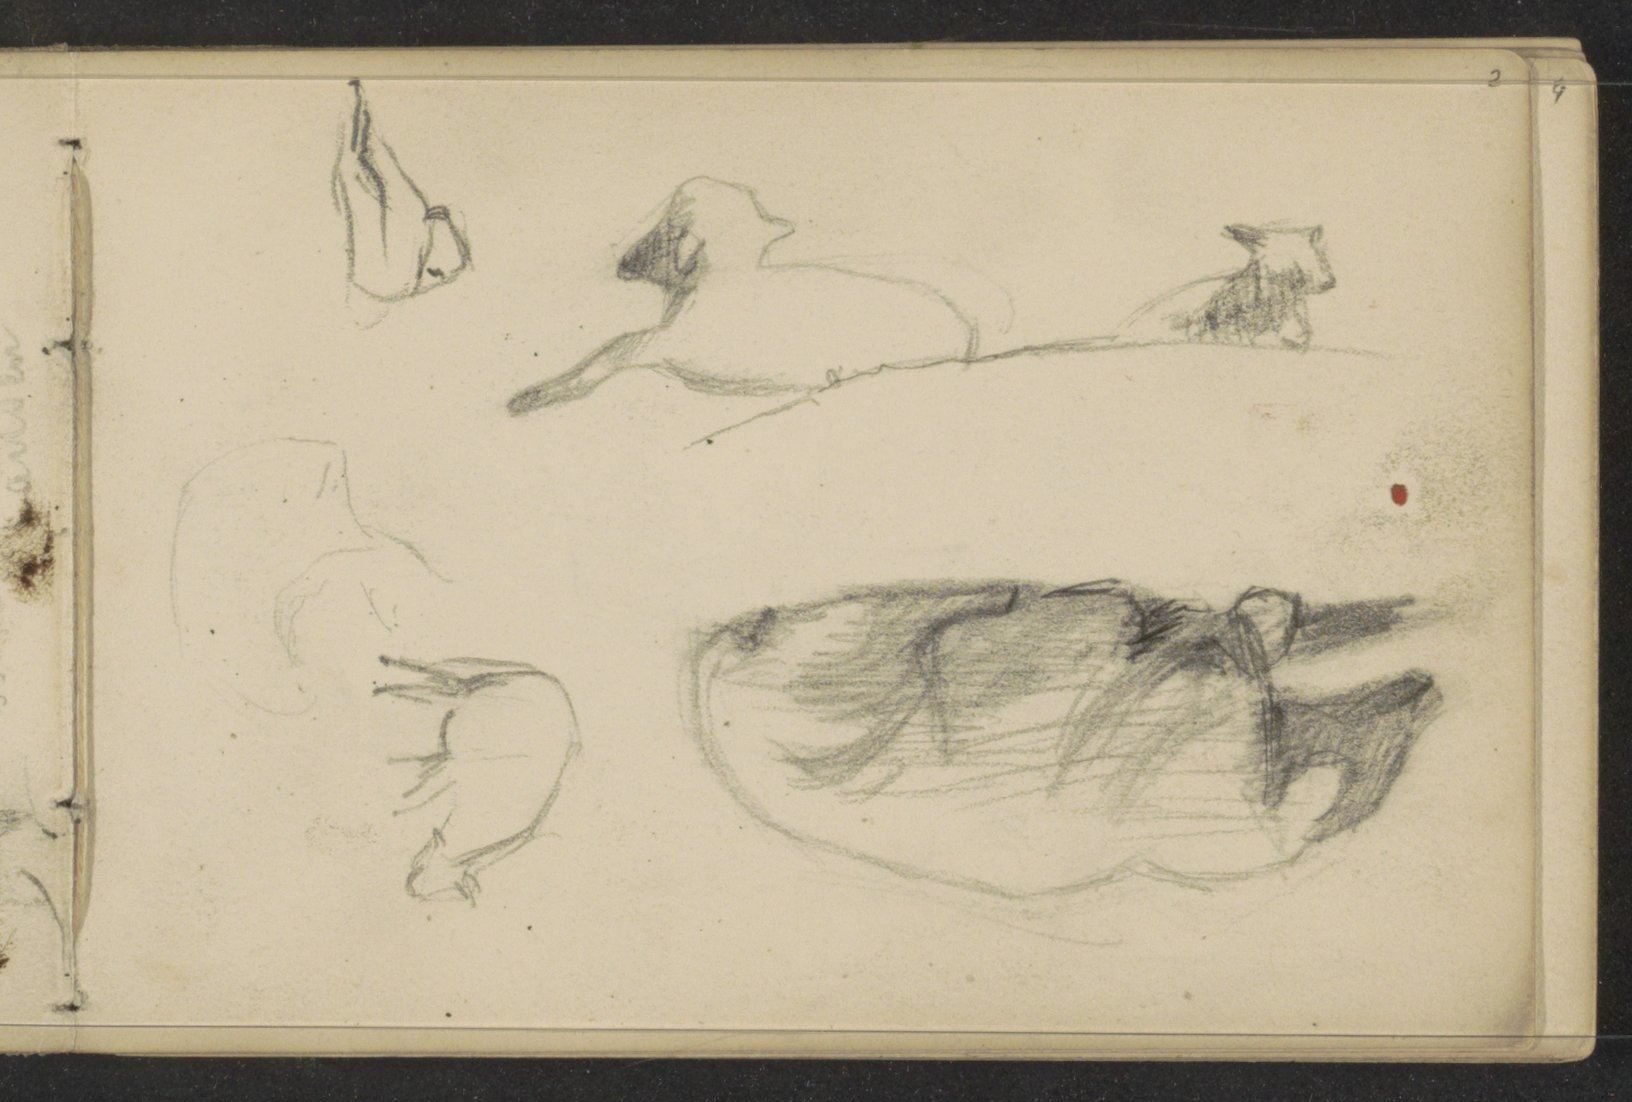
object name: sketchbook leaf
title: Studieblad met schapen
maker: Anonymous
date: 1880-1900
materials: paper, pencil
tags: sheep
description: Blad 2 recto uit een schetsboek met 29 bladen.